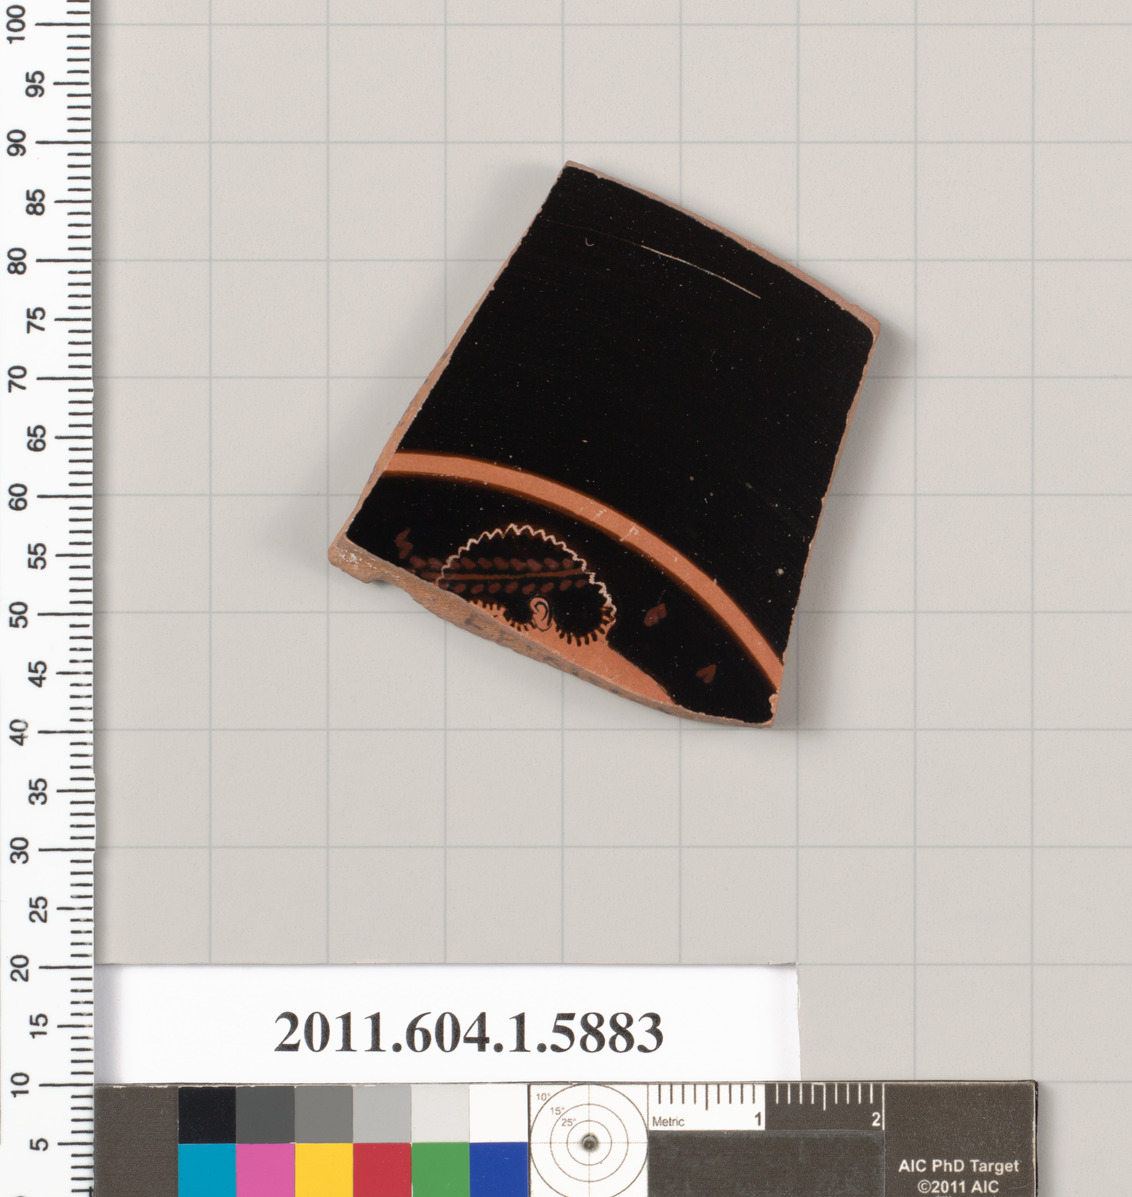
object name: kylix fragment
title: Terracotta fragment of a kylix (drinking cup)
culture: greek, attic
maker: epiktetos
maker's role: artist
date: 520-510 BCE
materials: terracotta